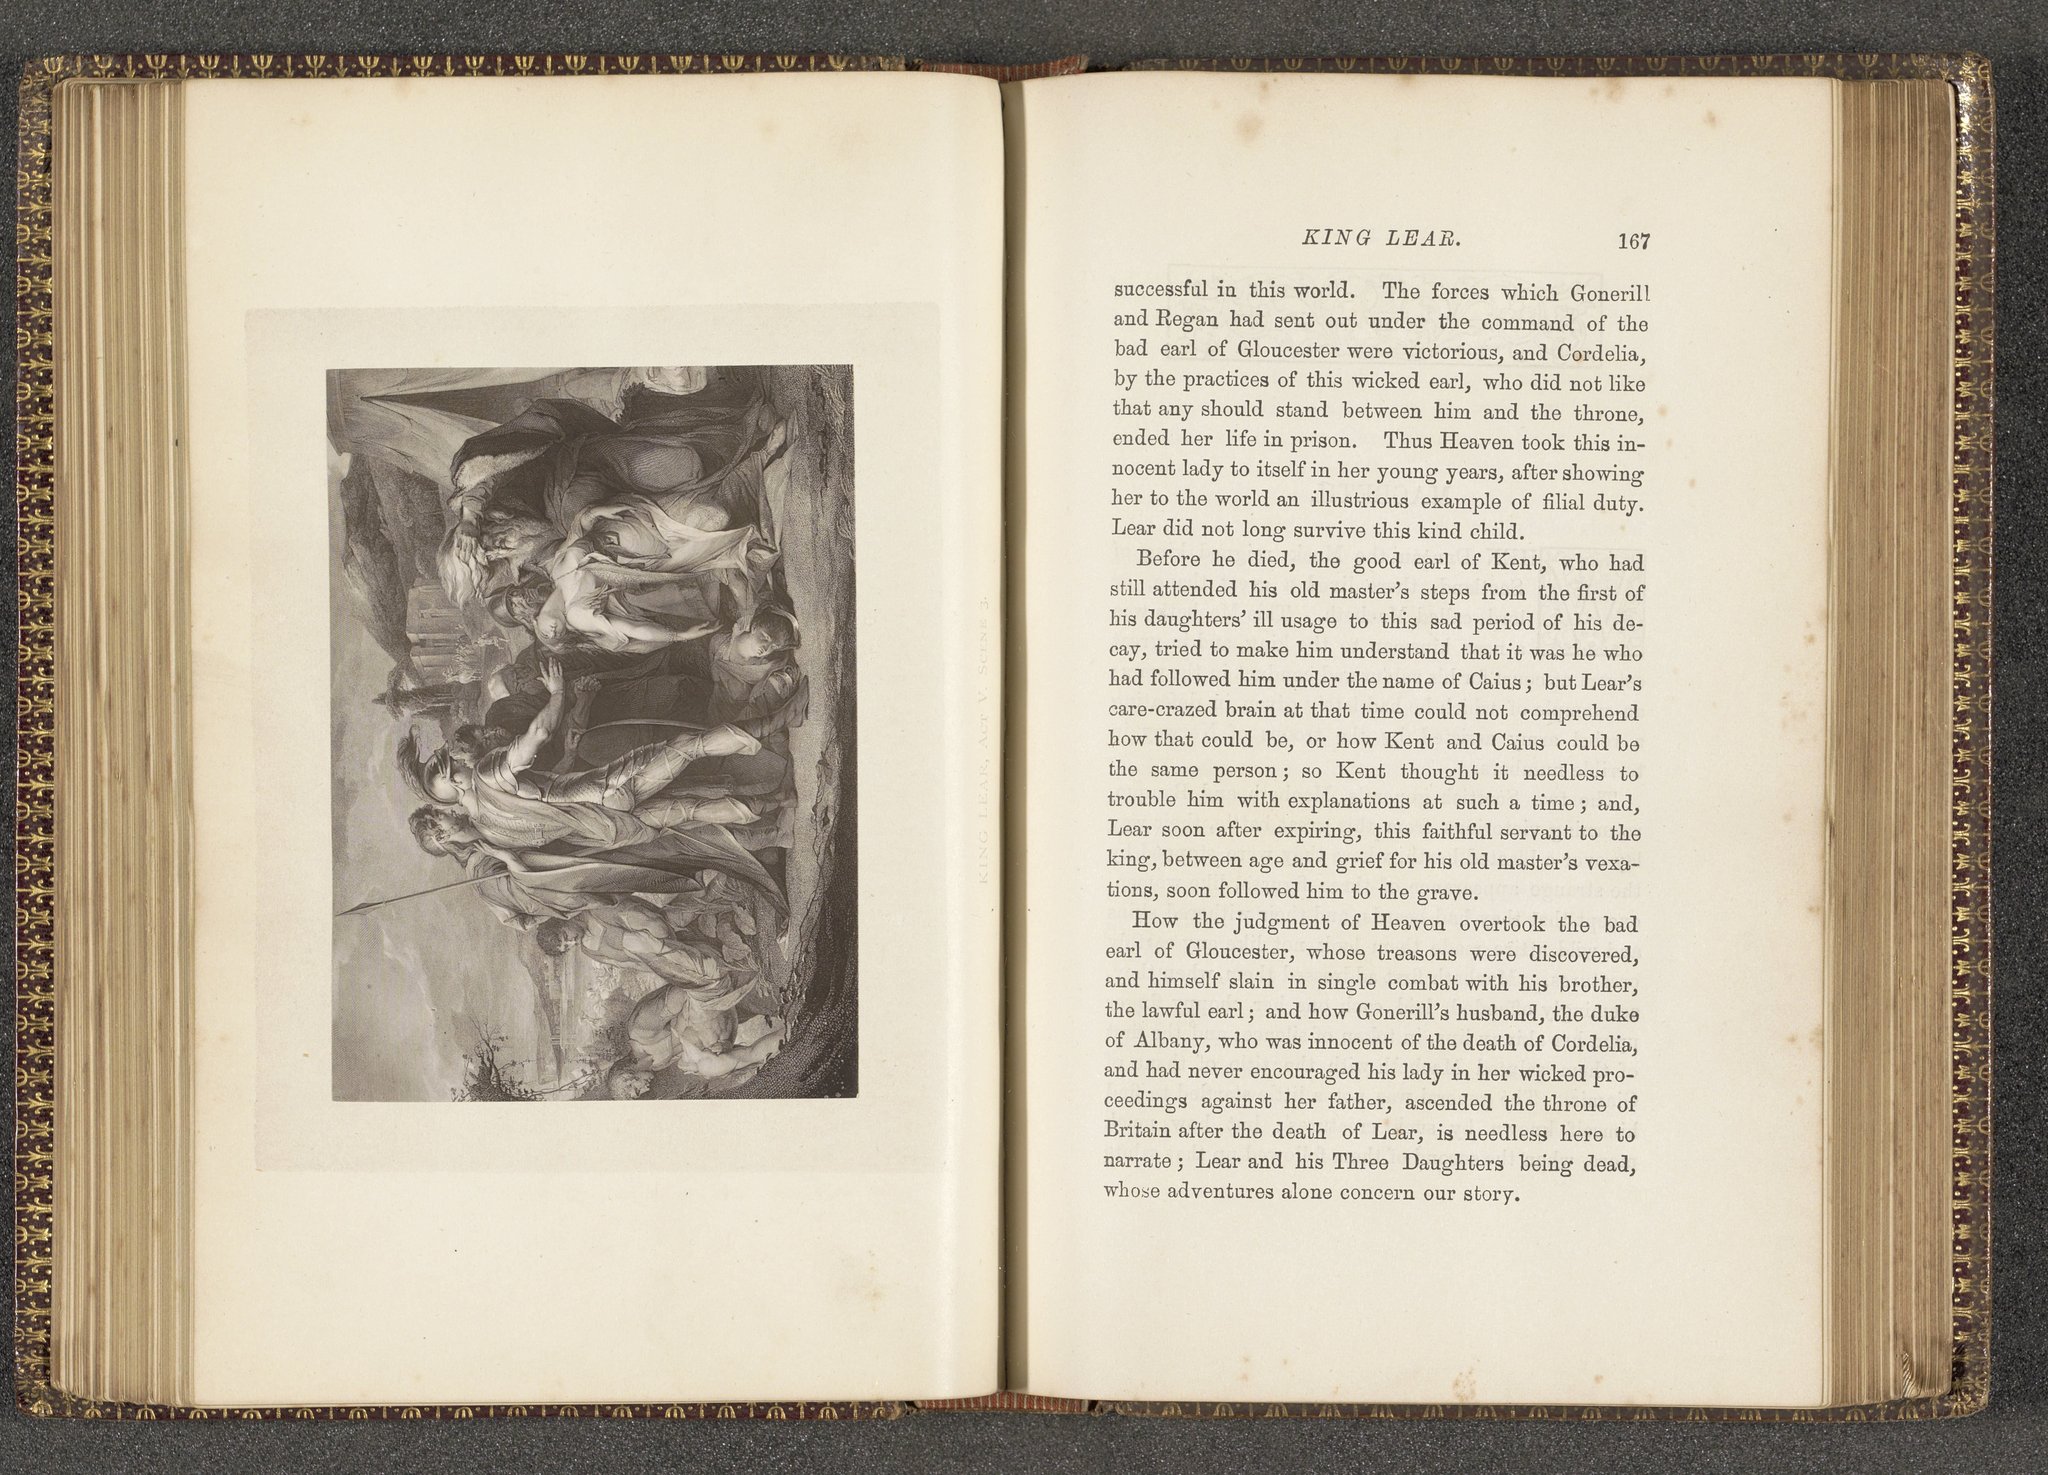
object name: reproduction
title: Fotoreproductie van een prent naar een schilderij door James Barry, voorstellend een scene uit King Lear door William Shakespeare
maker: Anonymous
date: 1873-1883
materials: paper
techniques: woodburytype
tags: theatre, theatrical performance, king lear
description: Te zien is King Lear met het lichaam van Cordelia in zijn handen.